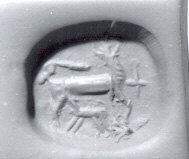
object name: stamp seal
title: Stamp seal (scaraboid) with animals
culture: neo-assyrian or syro-anatolian-levantine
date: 900-601 BCE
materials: glass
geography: northern syria or southeastern anatolia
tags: animals